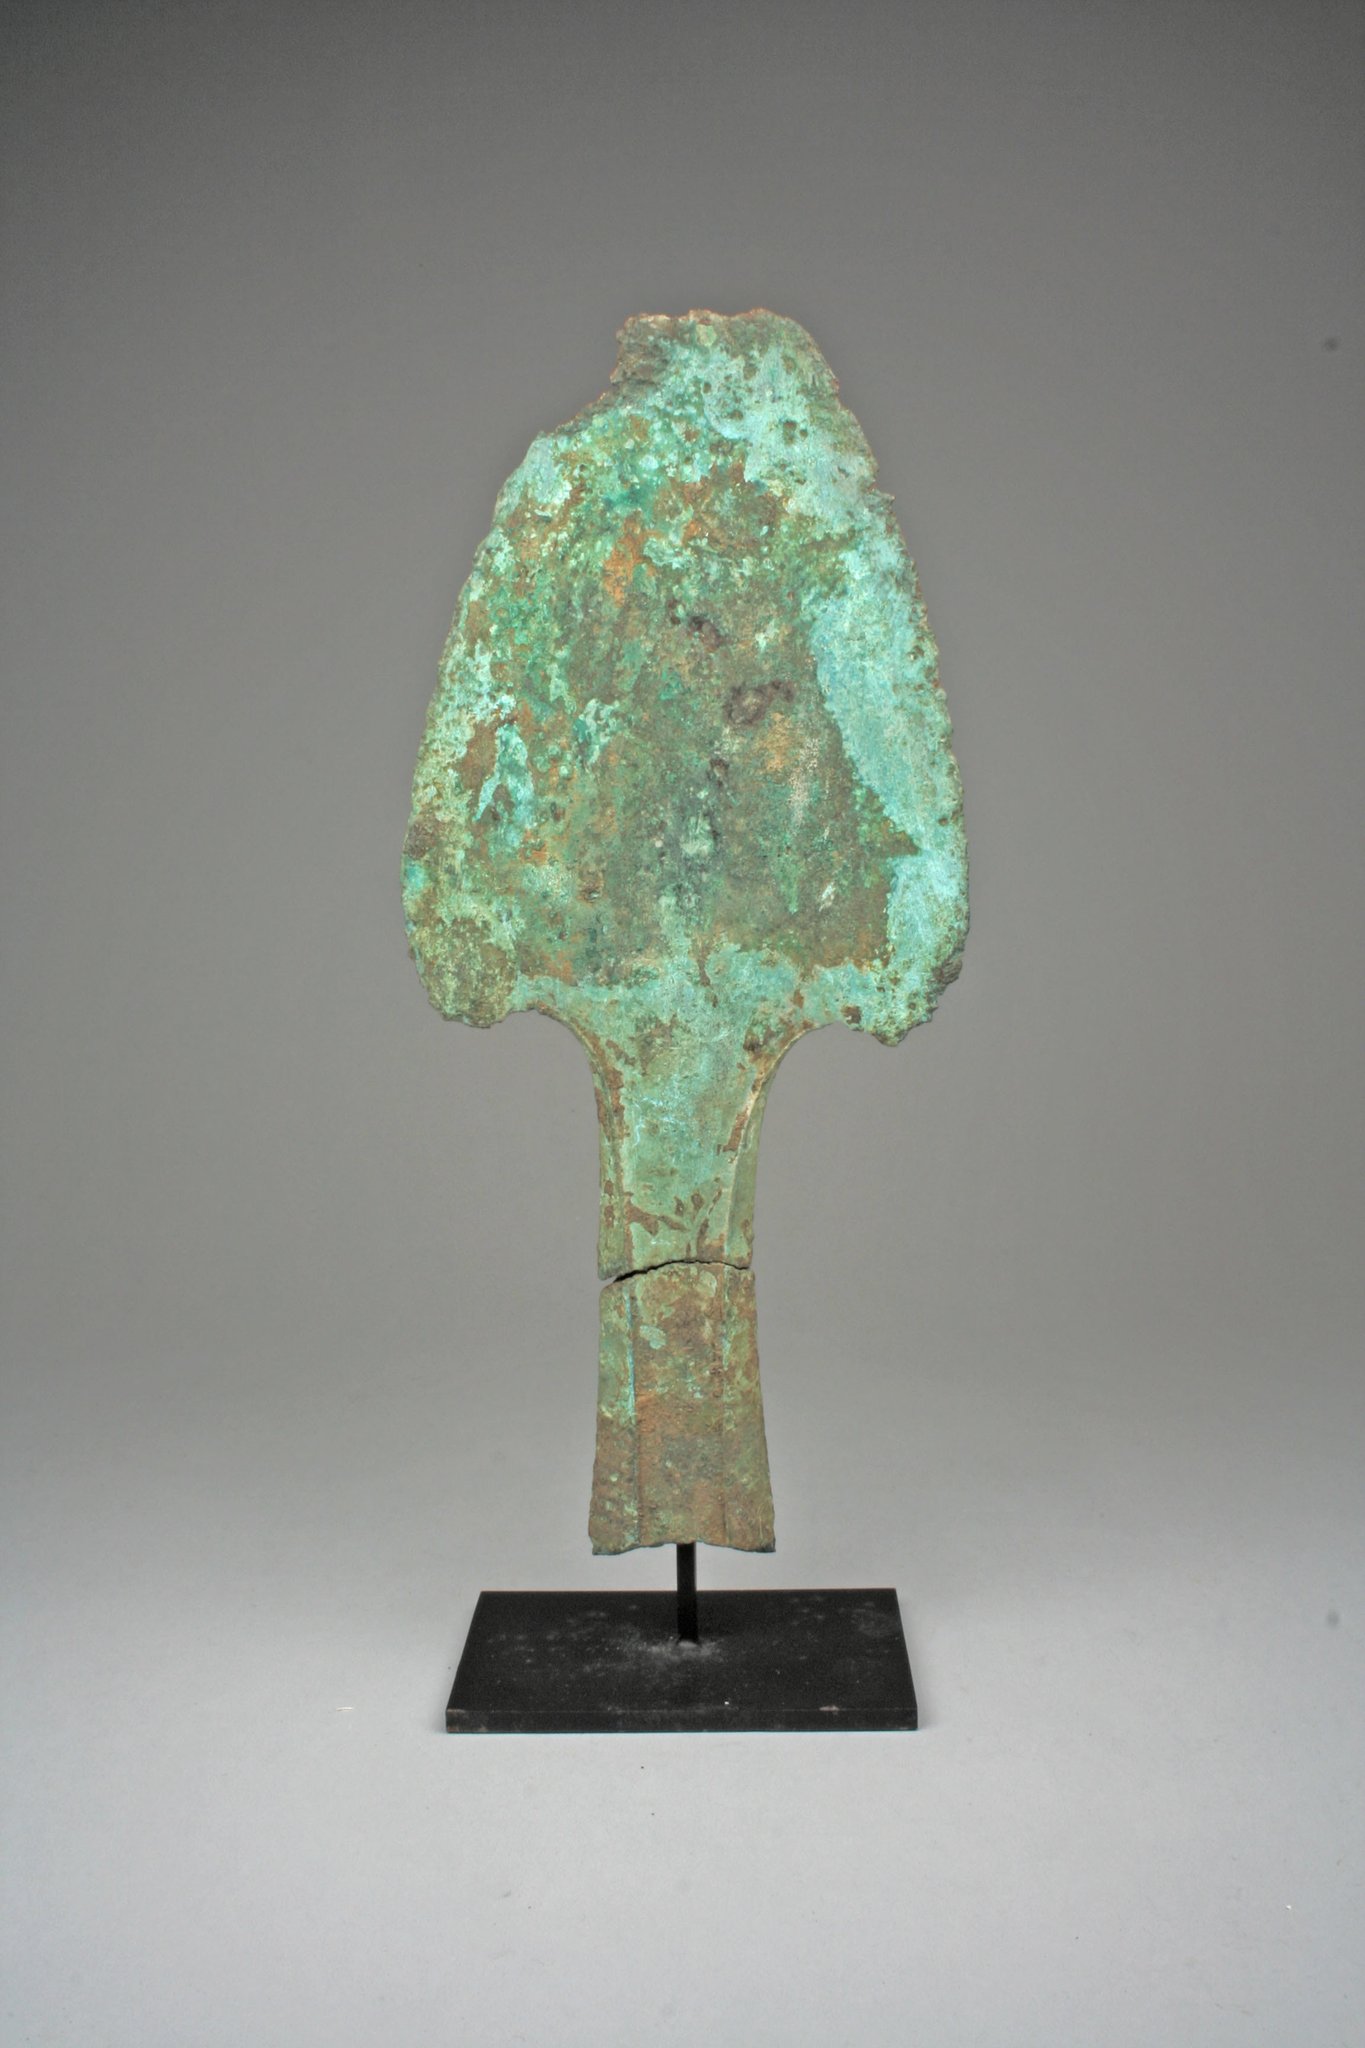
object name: axe blade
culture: dongson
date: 500 BCE-300 CE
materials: bronze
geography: indonesia